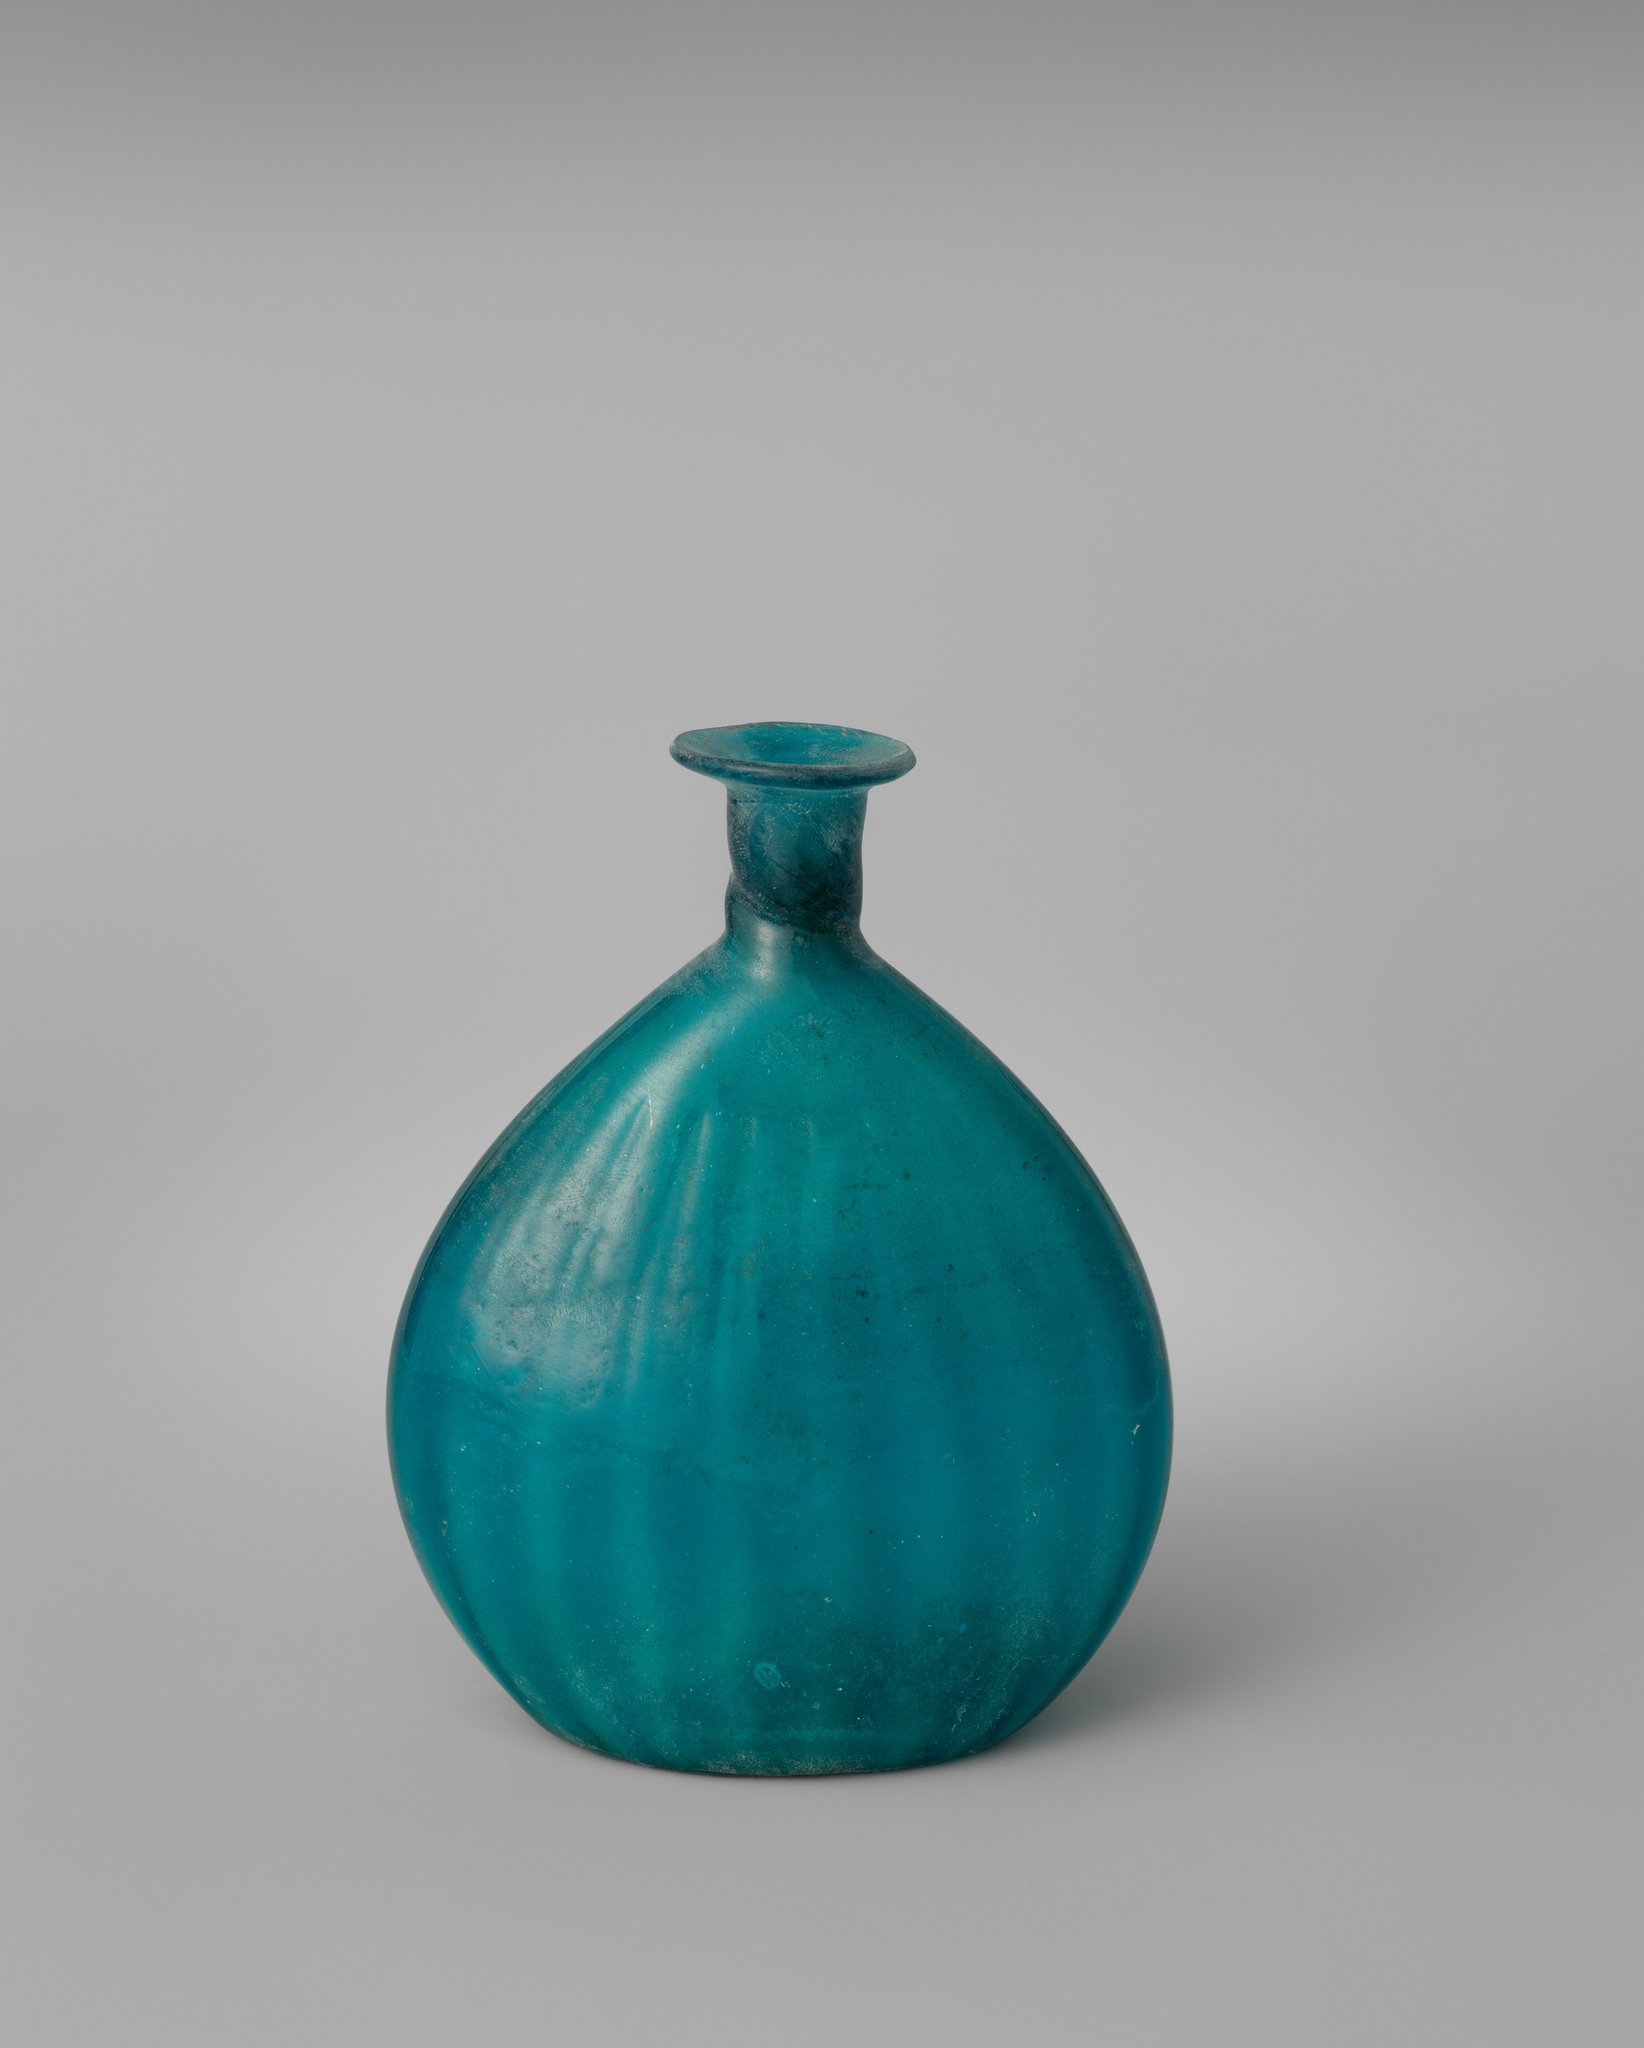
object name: bottle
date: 1701-1900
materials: glass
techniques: glassblowing, tooling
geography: iran